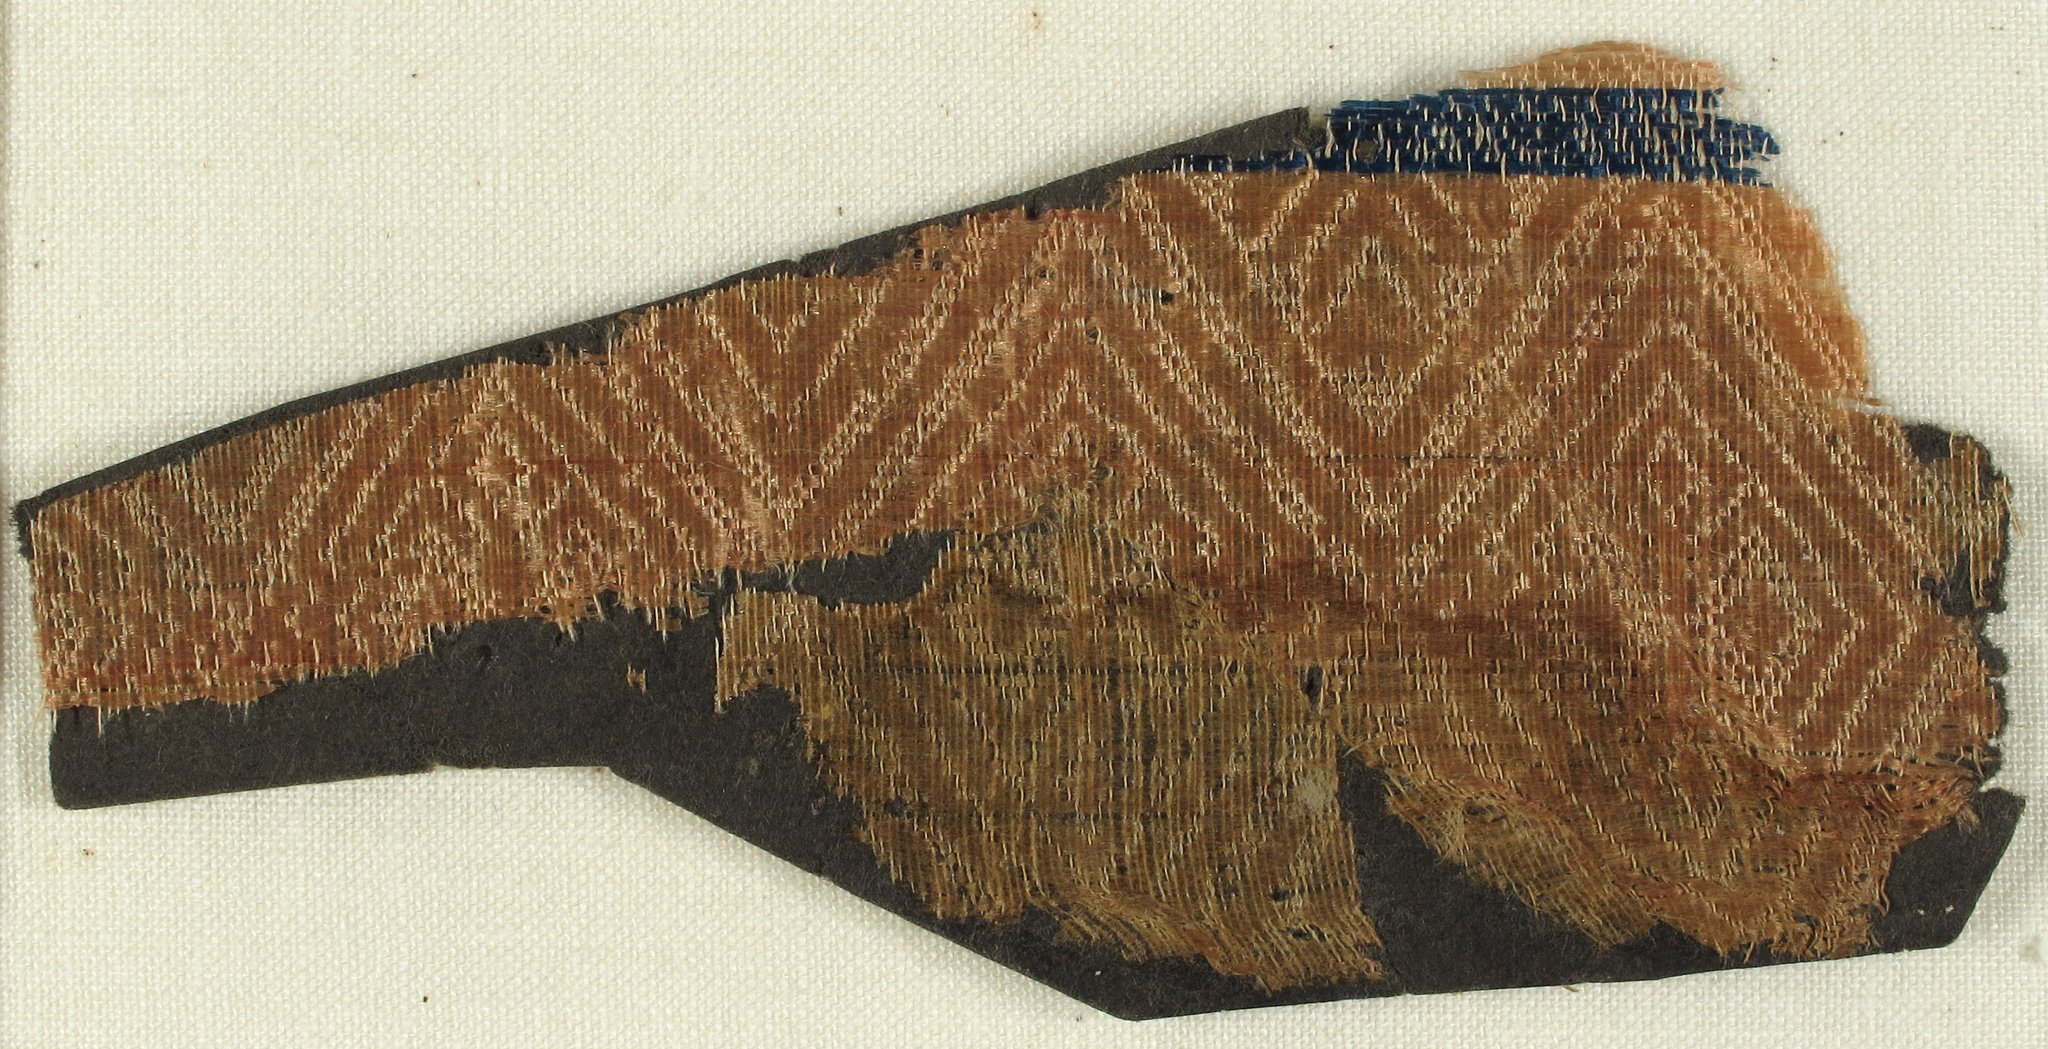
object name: textile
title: Textile with Old Rose in Diaper Pattern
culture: german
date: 1401-1500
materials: metal thread, silk